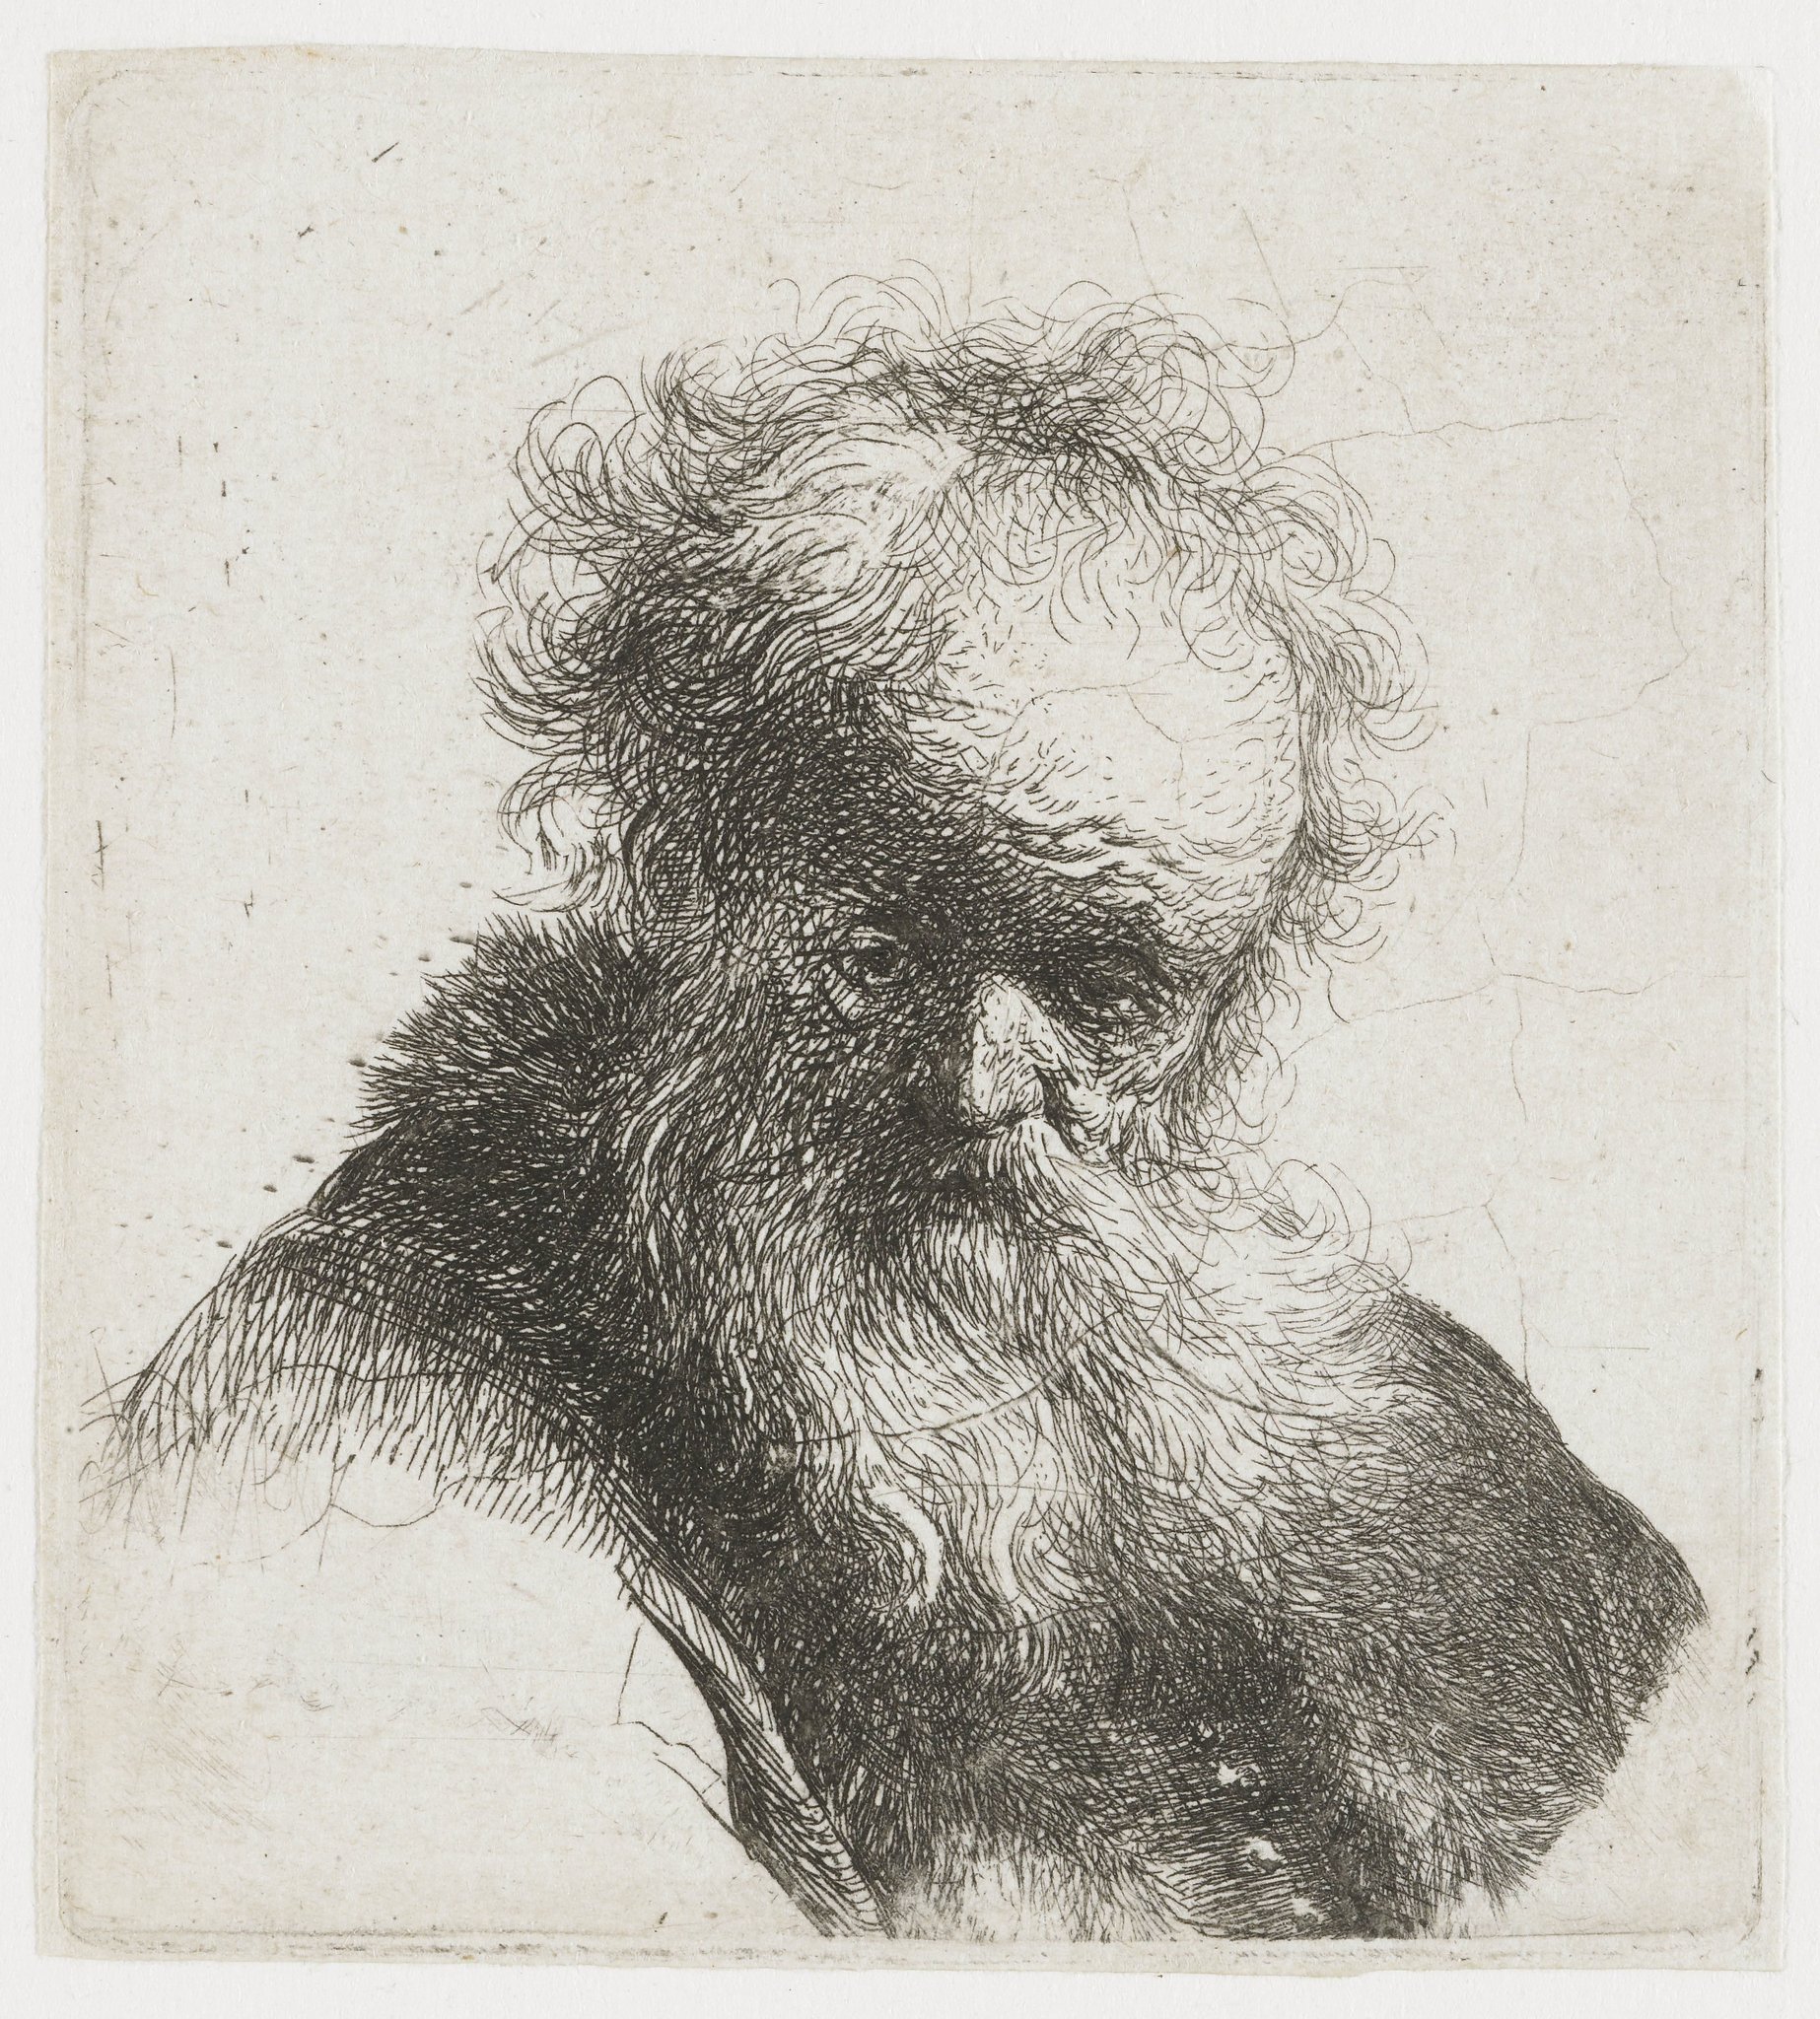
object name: print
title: Old Man with a Flowing Beard and White Sleeve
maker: rembrandt van rijn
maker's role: draughtsman, painter, print maker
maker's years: 1606-1669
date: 1630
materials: paper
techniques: etching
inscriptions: collector's mark: Lugt 240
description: In these prints, Rembrandt studies the characteristics of age, always portraying the same full-bearded man. While slight differences can certainly be discerned, Rembrandt’s penchant for depicting his models while they look down, their heads slightly bent, is striking. This pose lends the studies a melancholy air.